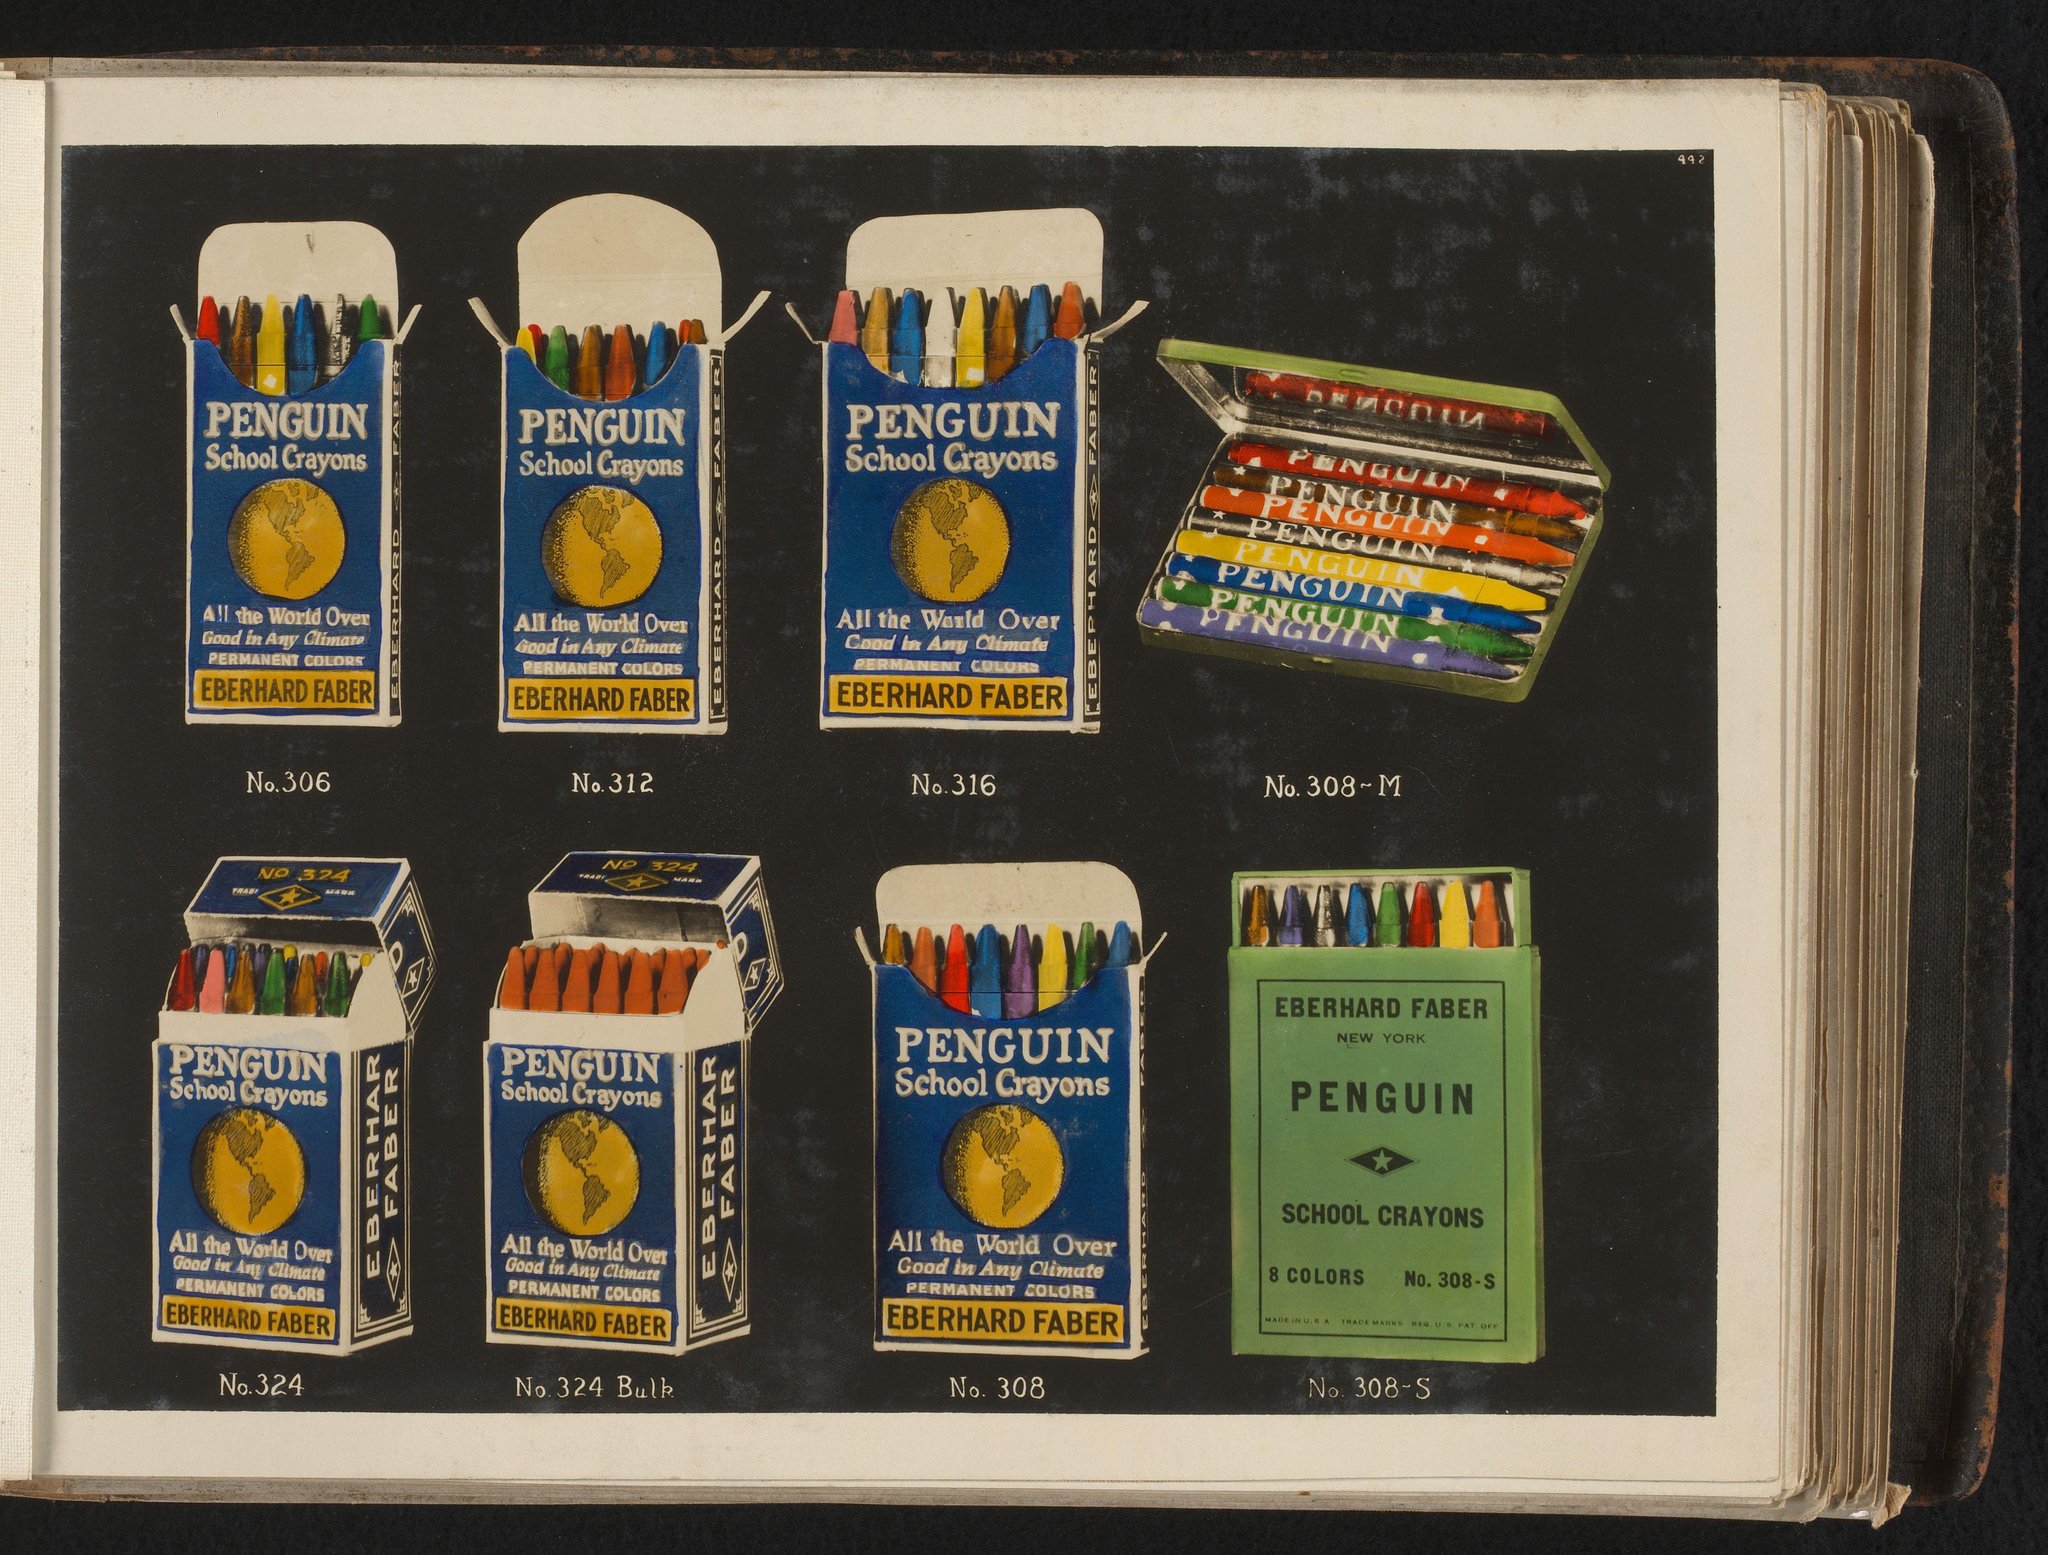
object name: album leaf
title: Sets met krijt van Eberhard Faber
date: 1915-1935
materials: paper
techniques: gelatin silver print, hand coloring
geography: springfield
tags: writing tools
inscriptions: stamp: ‘Paramount/ Commercial Studios/ 145 Chestnut St./ Springfield - Mass.’, number: ‘442’